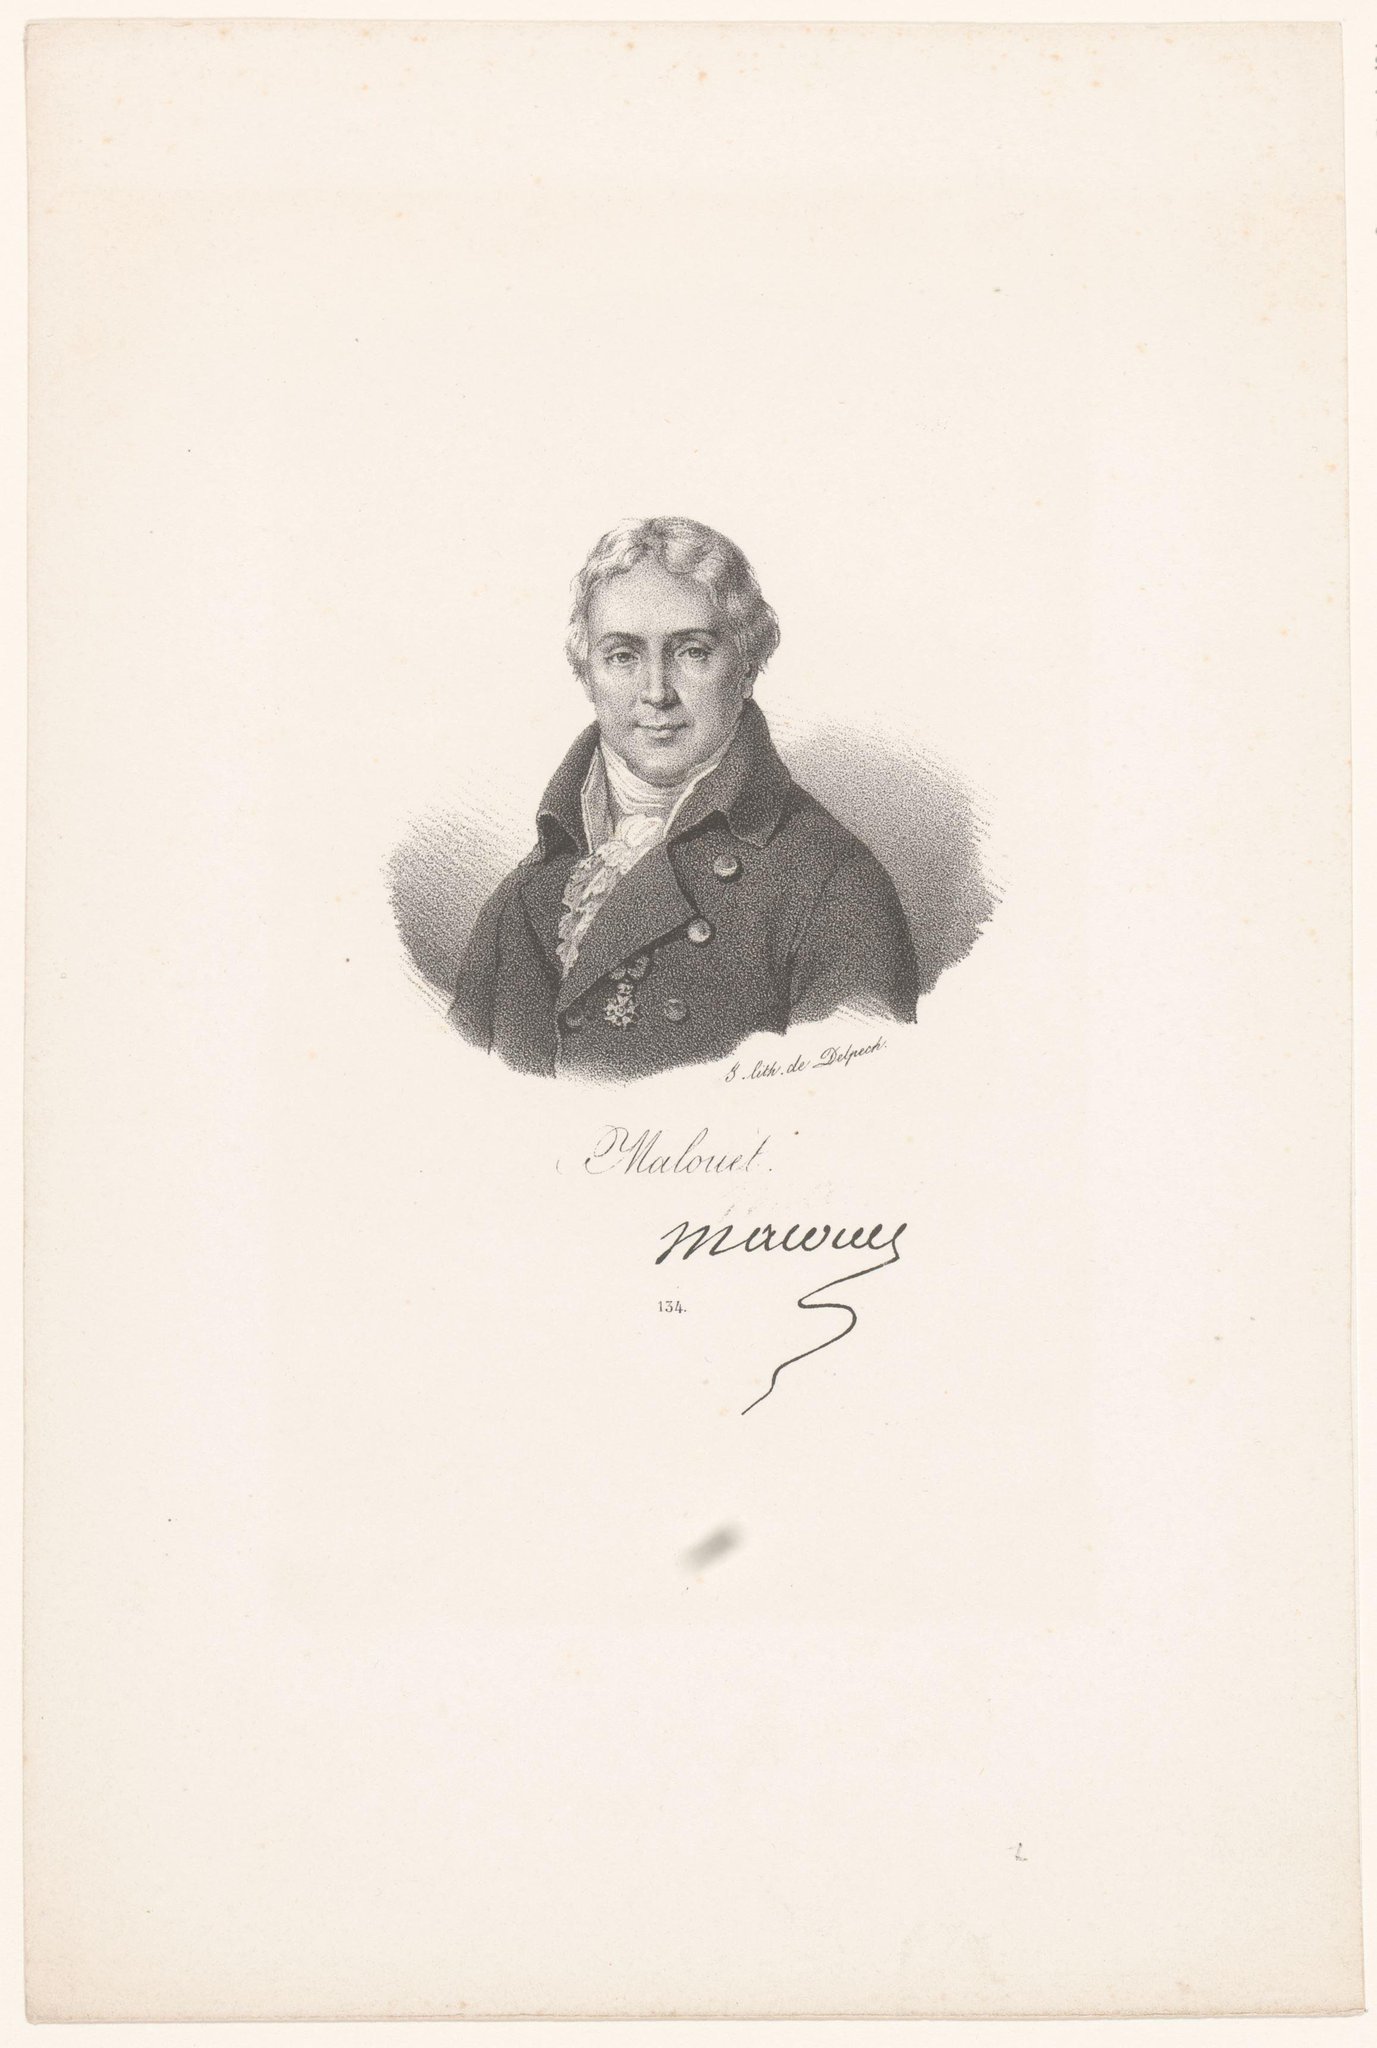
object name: print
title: Malouet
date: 1818-1842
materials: paper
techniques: lithograph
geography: paris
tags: paris, politician, historical persons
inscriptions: collector's mark: Lugt 2228a